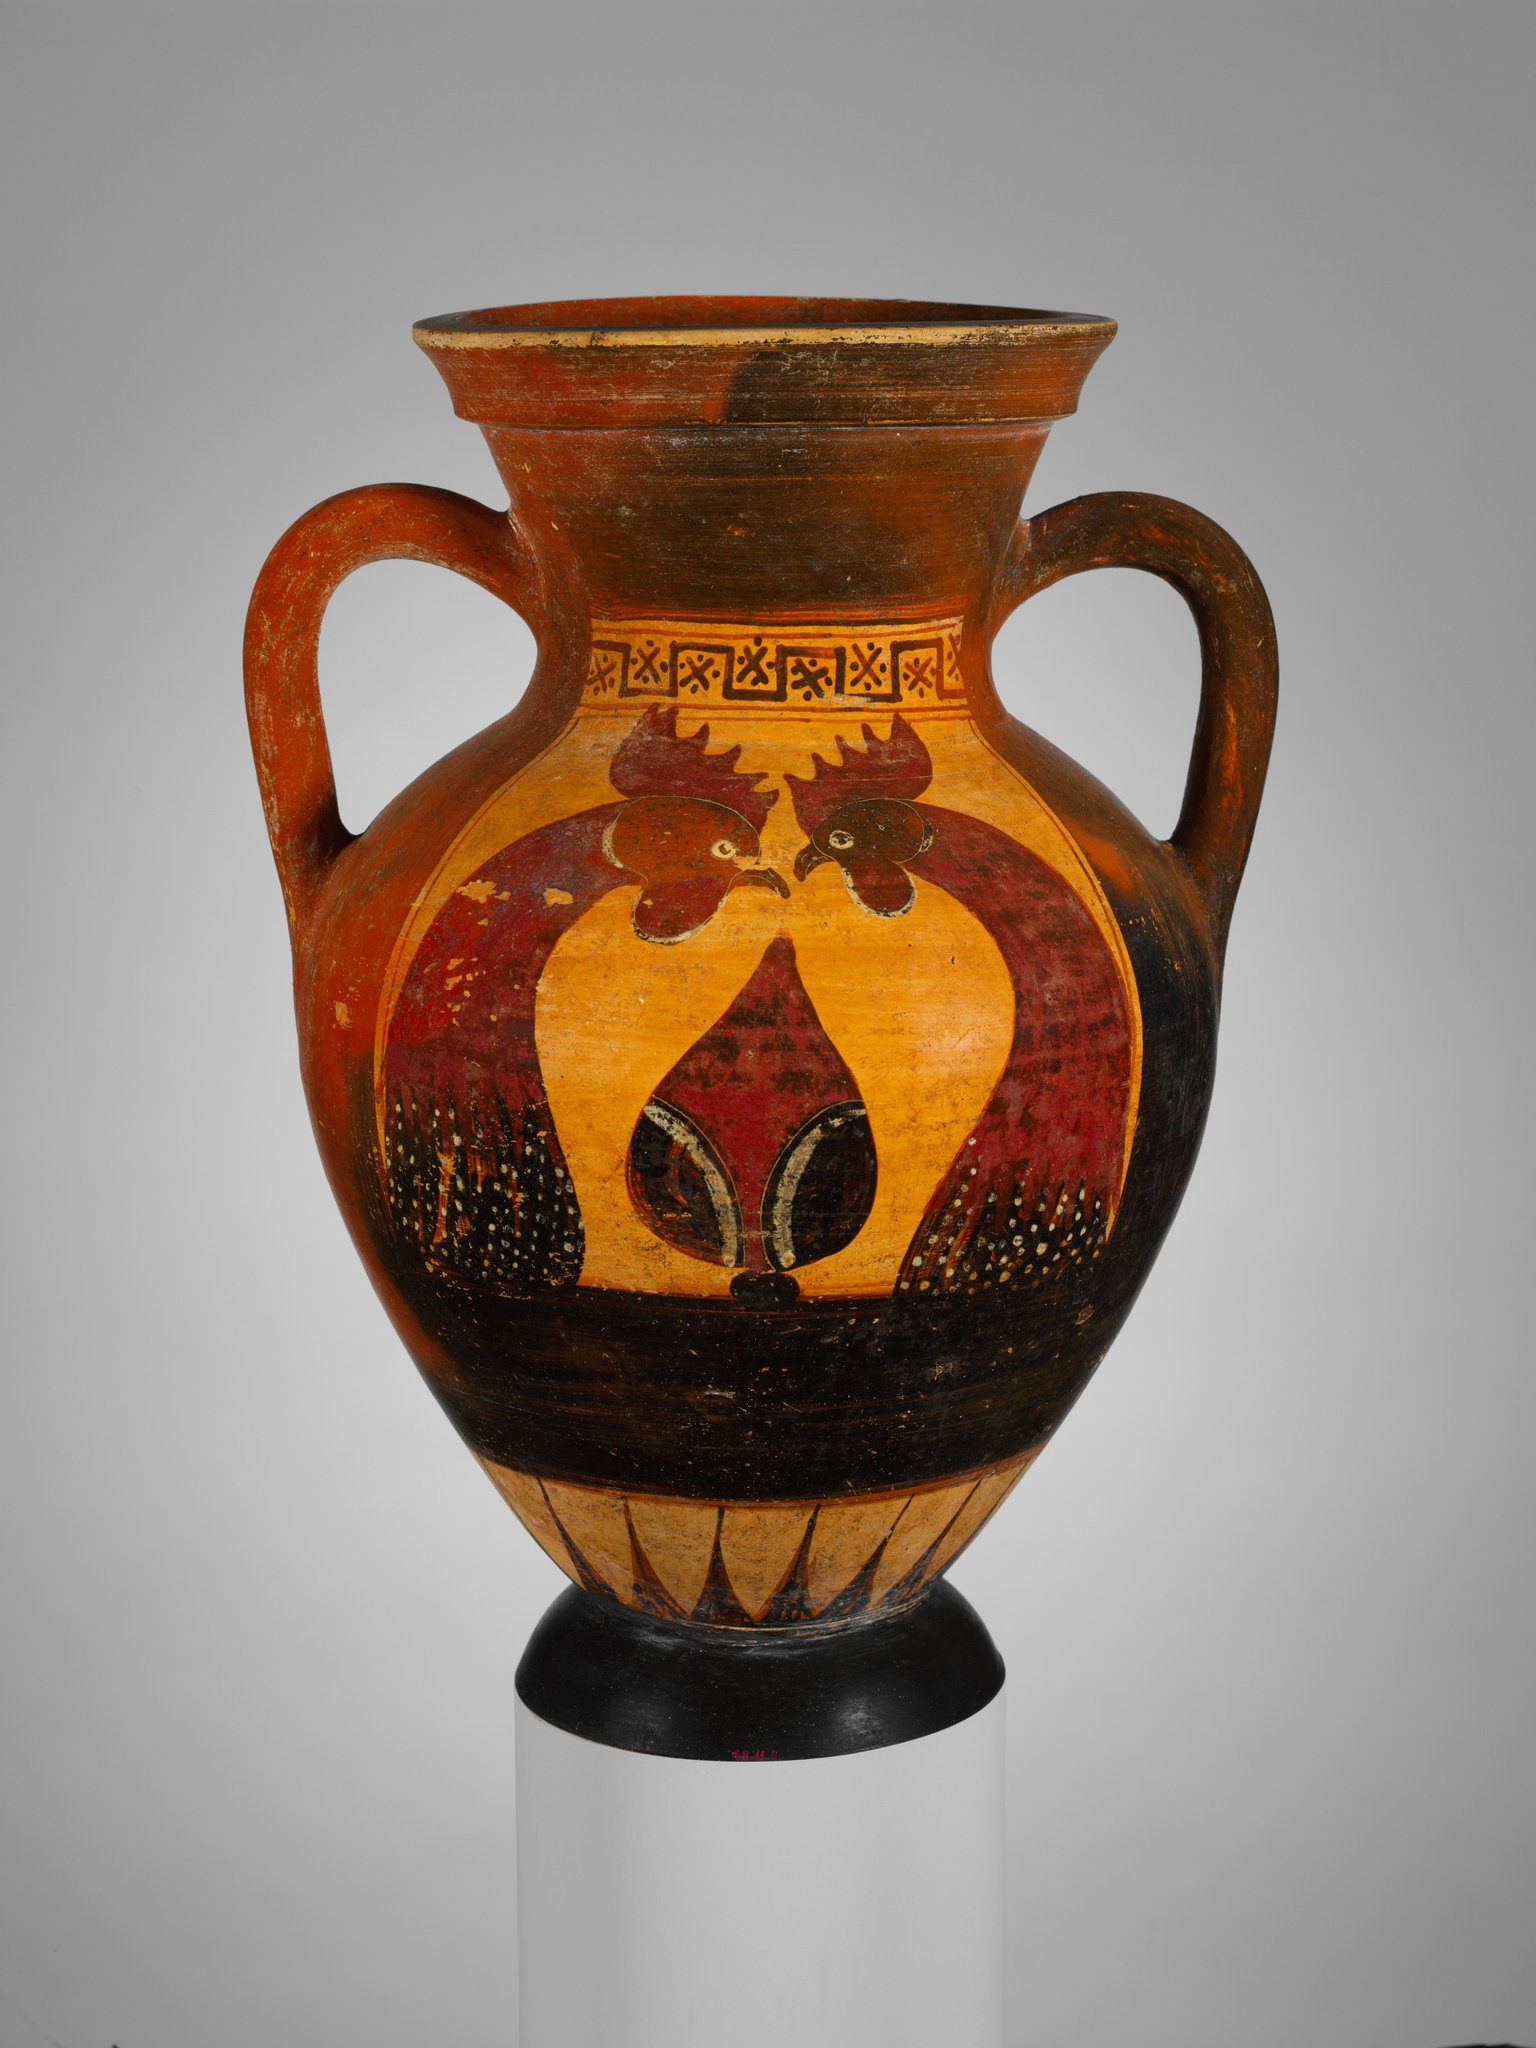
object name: amphora, type b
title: Terracotta amphora (jar)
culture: etruscan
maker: ivy leaf group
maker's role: artist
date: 540-530 BCE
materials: terracotta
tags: roosters